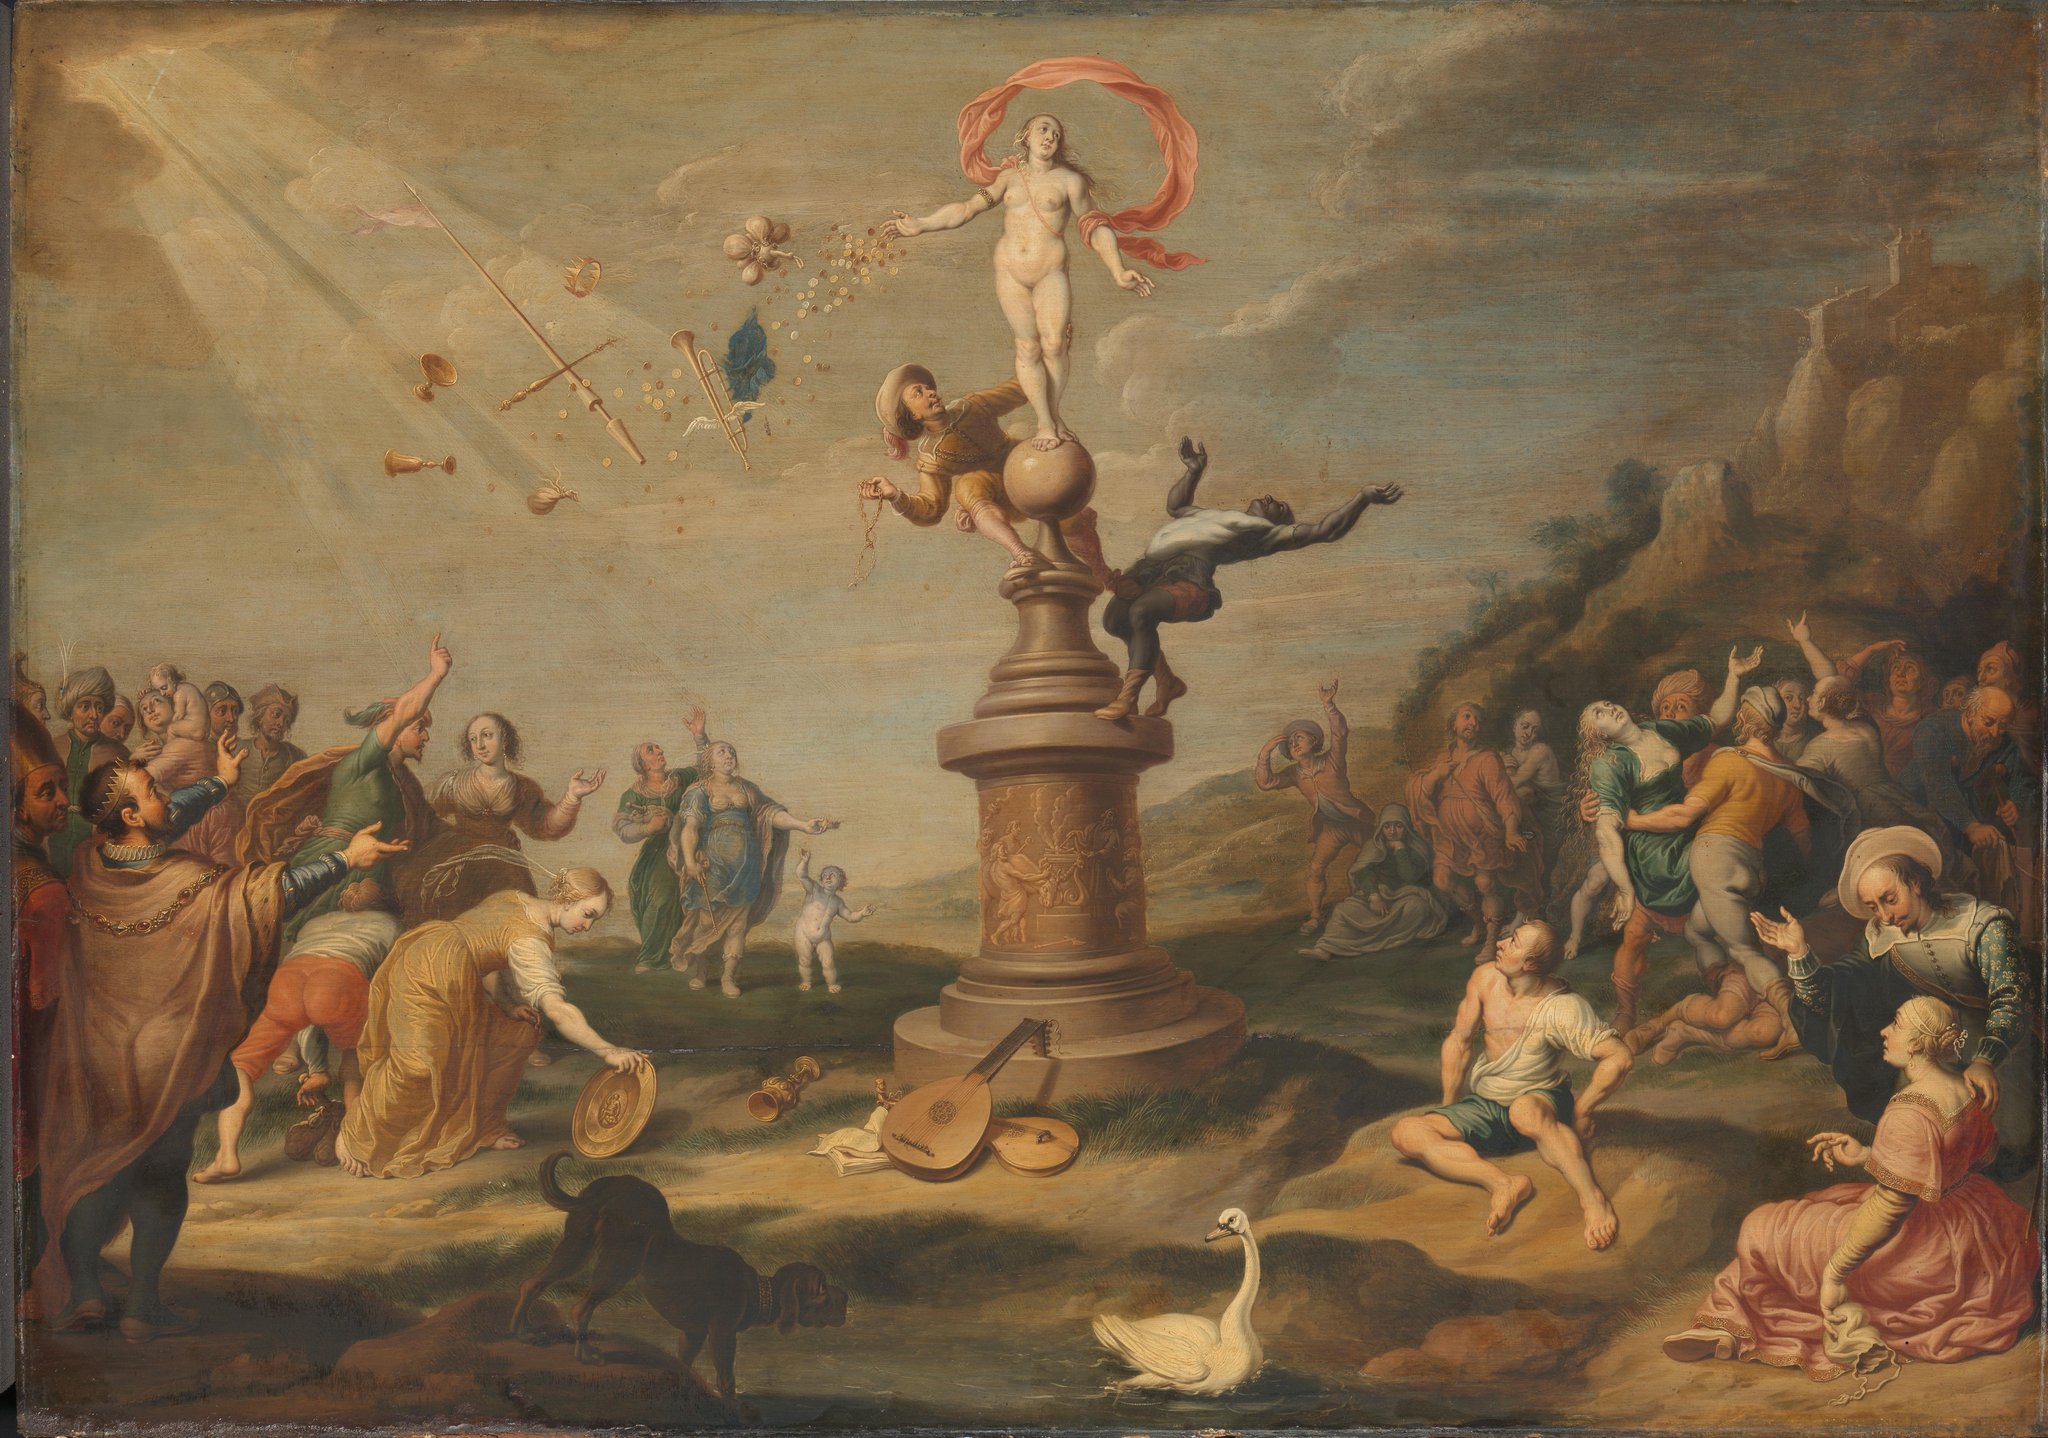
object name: painting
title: The Goddess Fortuna Bestowing her Gifts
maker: simon flocquet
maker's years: 1607-1678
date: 1645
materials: oil, panel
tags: africans, adversity, misfortune, bad luck; 'fortuna infelice', 'infortunio' (ripa), luck, fortune, lot; 'fato', 'fortuna', 'fortuna aurea', 'fortuna buona', 'fortuna pacifica overo clemente', 'sorte' (ripa)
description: De naakte personificatie van Fortuna staande op een voetstuk strooit met geld en symbolen van eer en macht. Een zwarte man heeft geen geluk en valt van het voetstuk af. De toeschouwers links profiteren van haar gaven, de personen rechts moeten deze ontberen. Op de voorgrond een hond die een zwaan bedreigt. Bij het voetstuk een luit en een ander muziekinstrument.